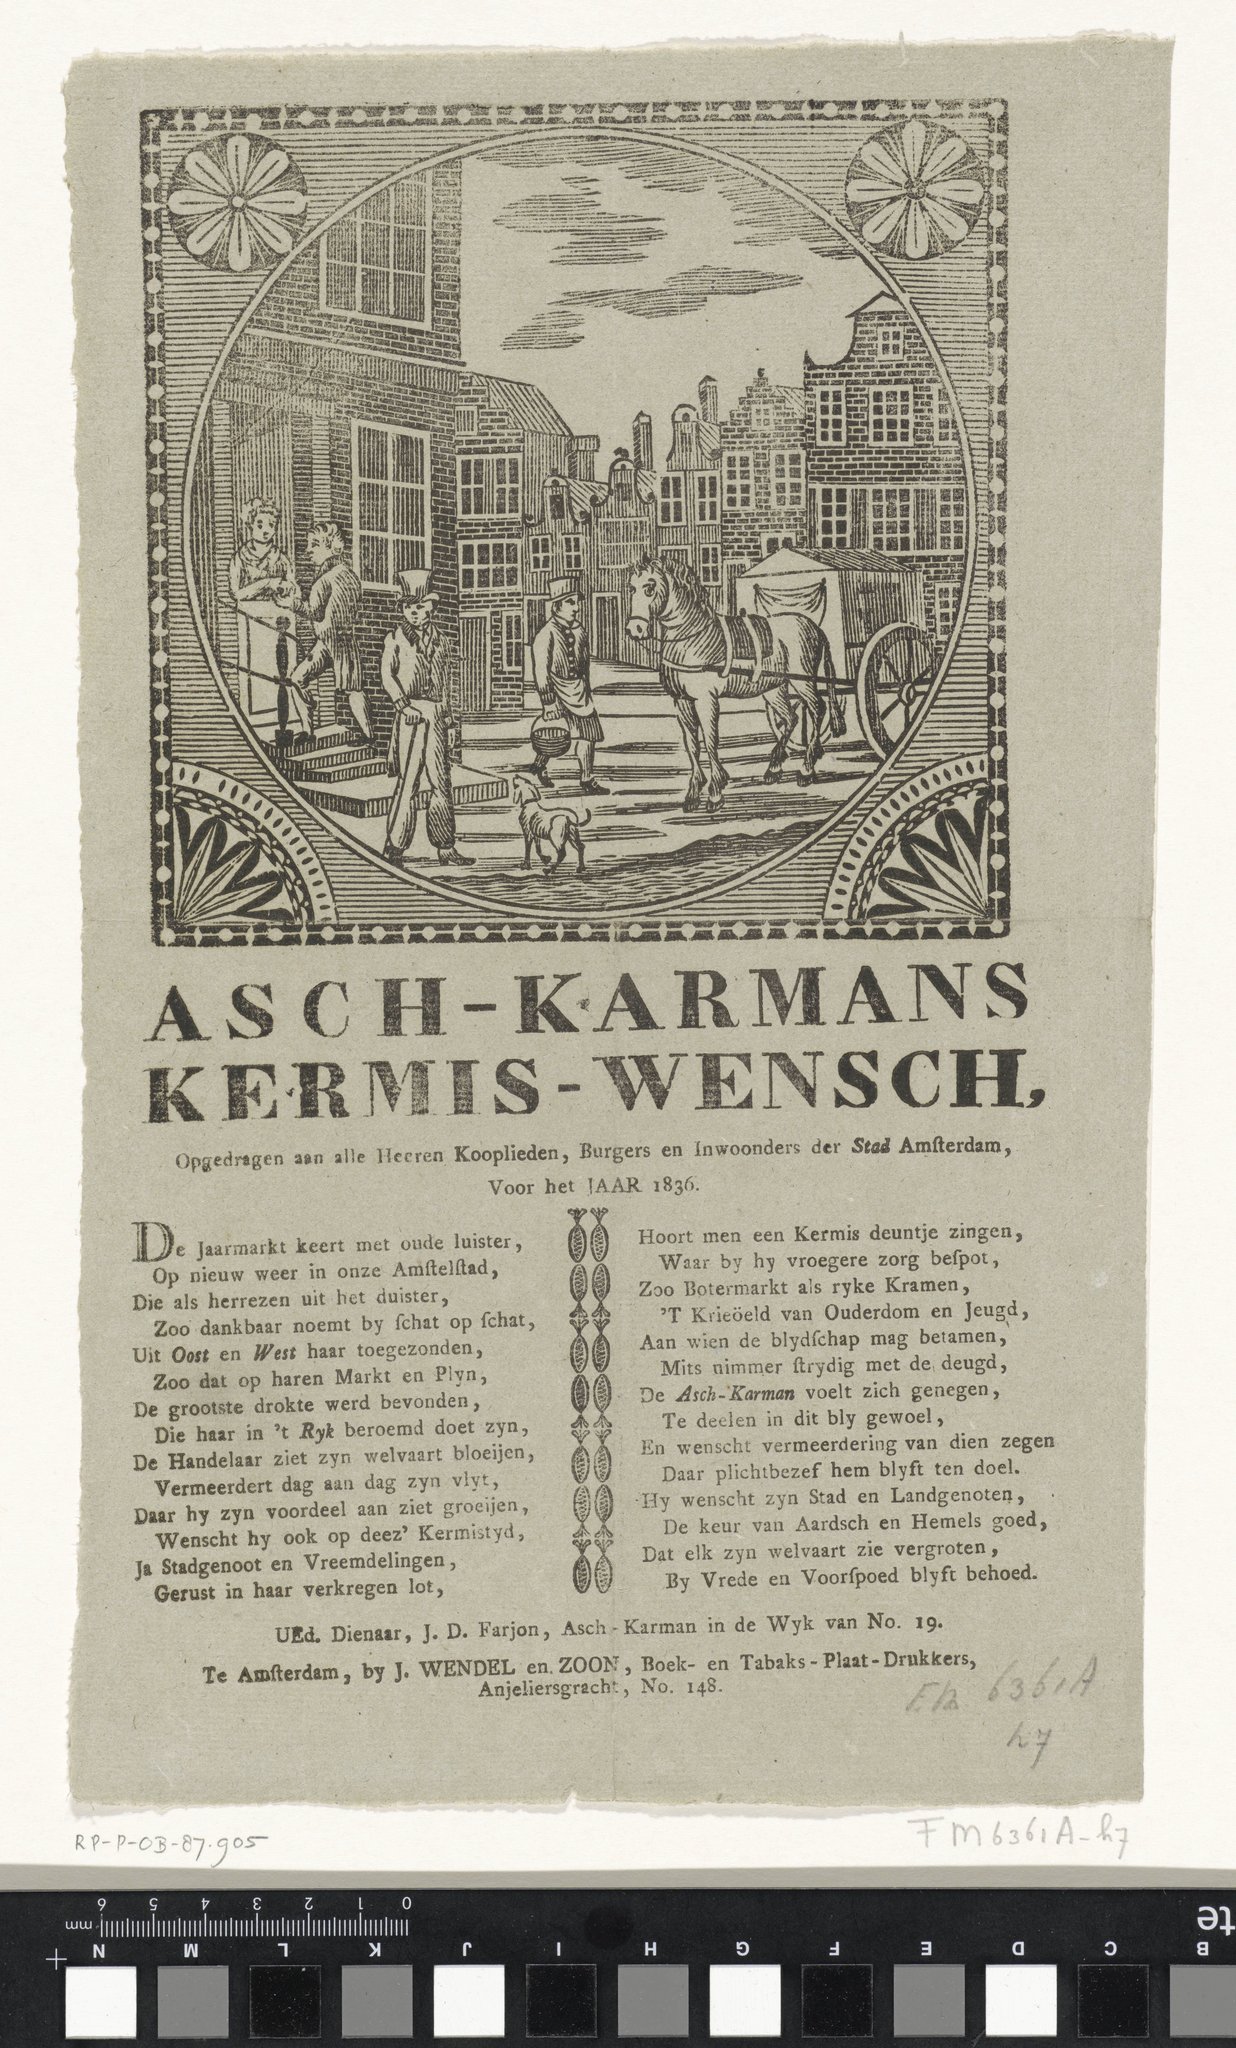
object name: fair print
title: Asch-Karmans Kermis-Wensch (...) 1836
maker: Anonymous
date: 1836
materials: paper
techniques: letterpress printing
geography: amsterdam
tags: public road - ii - ideal city, garbage collection, amsterdam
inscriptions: collector's mark: Lugt 2228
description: Kermisprent namens de askarrenmannen (karrenman of vuilnisman) te Amsterdam voor het jaar 1836. Gezicht in een straat te Amsterdam met een man die een asemmer naar de kar brengt terwijl een andere man aan huis geld ophaalt. Onderaan een gedicht in twee kolommen. Namens J.D. Farjon, de askarreman van wijk no. 19.